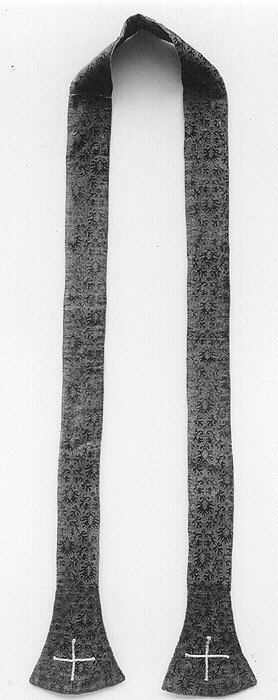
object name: stole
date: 1601-1633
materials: metal thread, silk, velvet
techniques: brocade